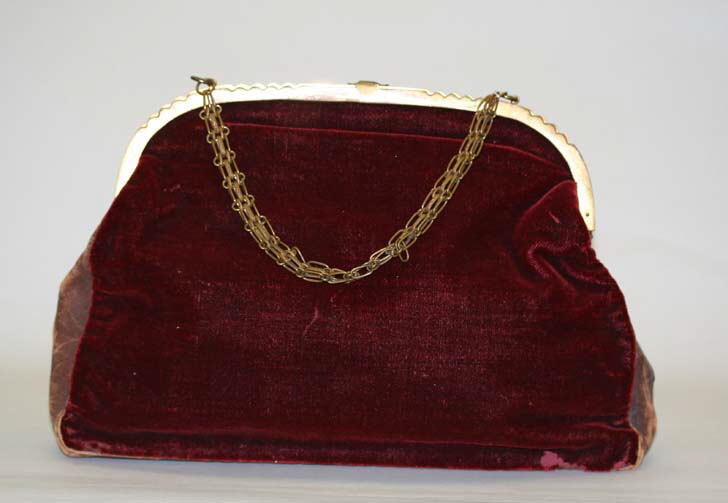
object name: purse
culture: european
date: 1820